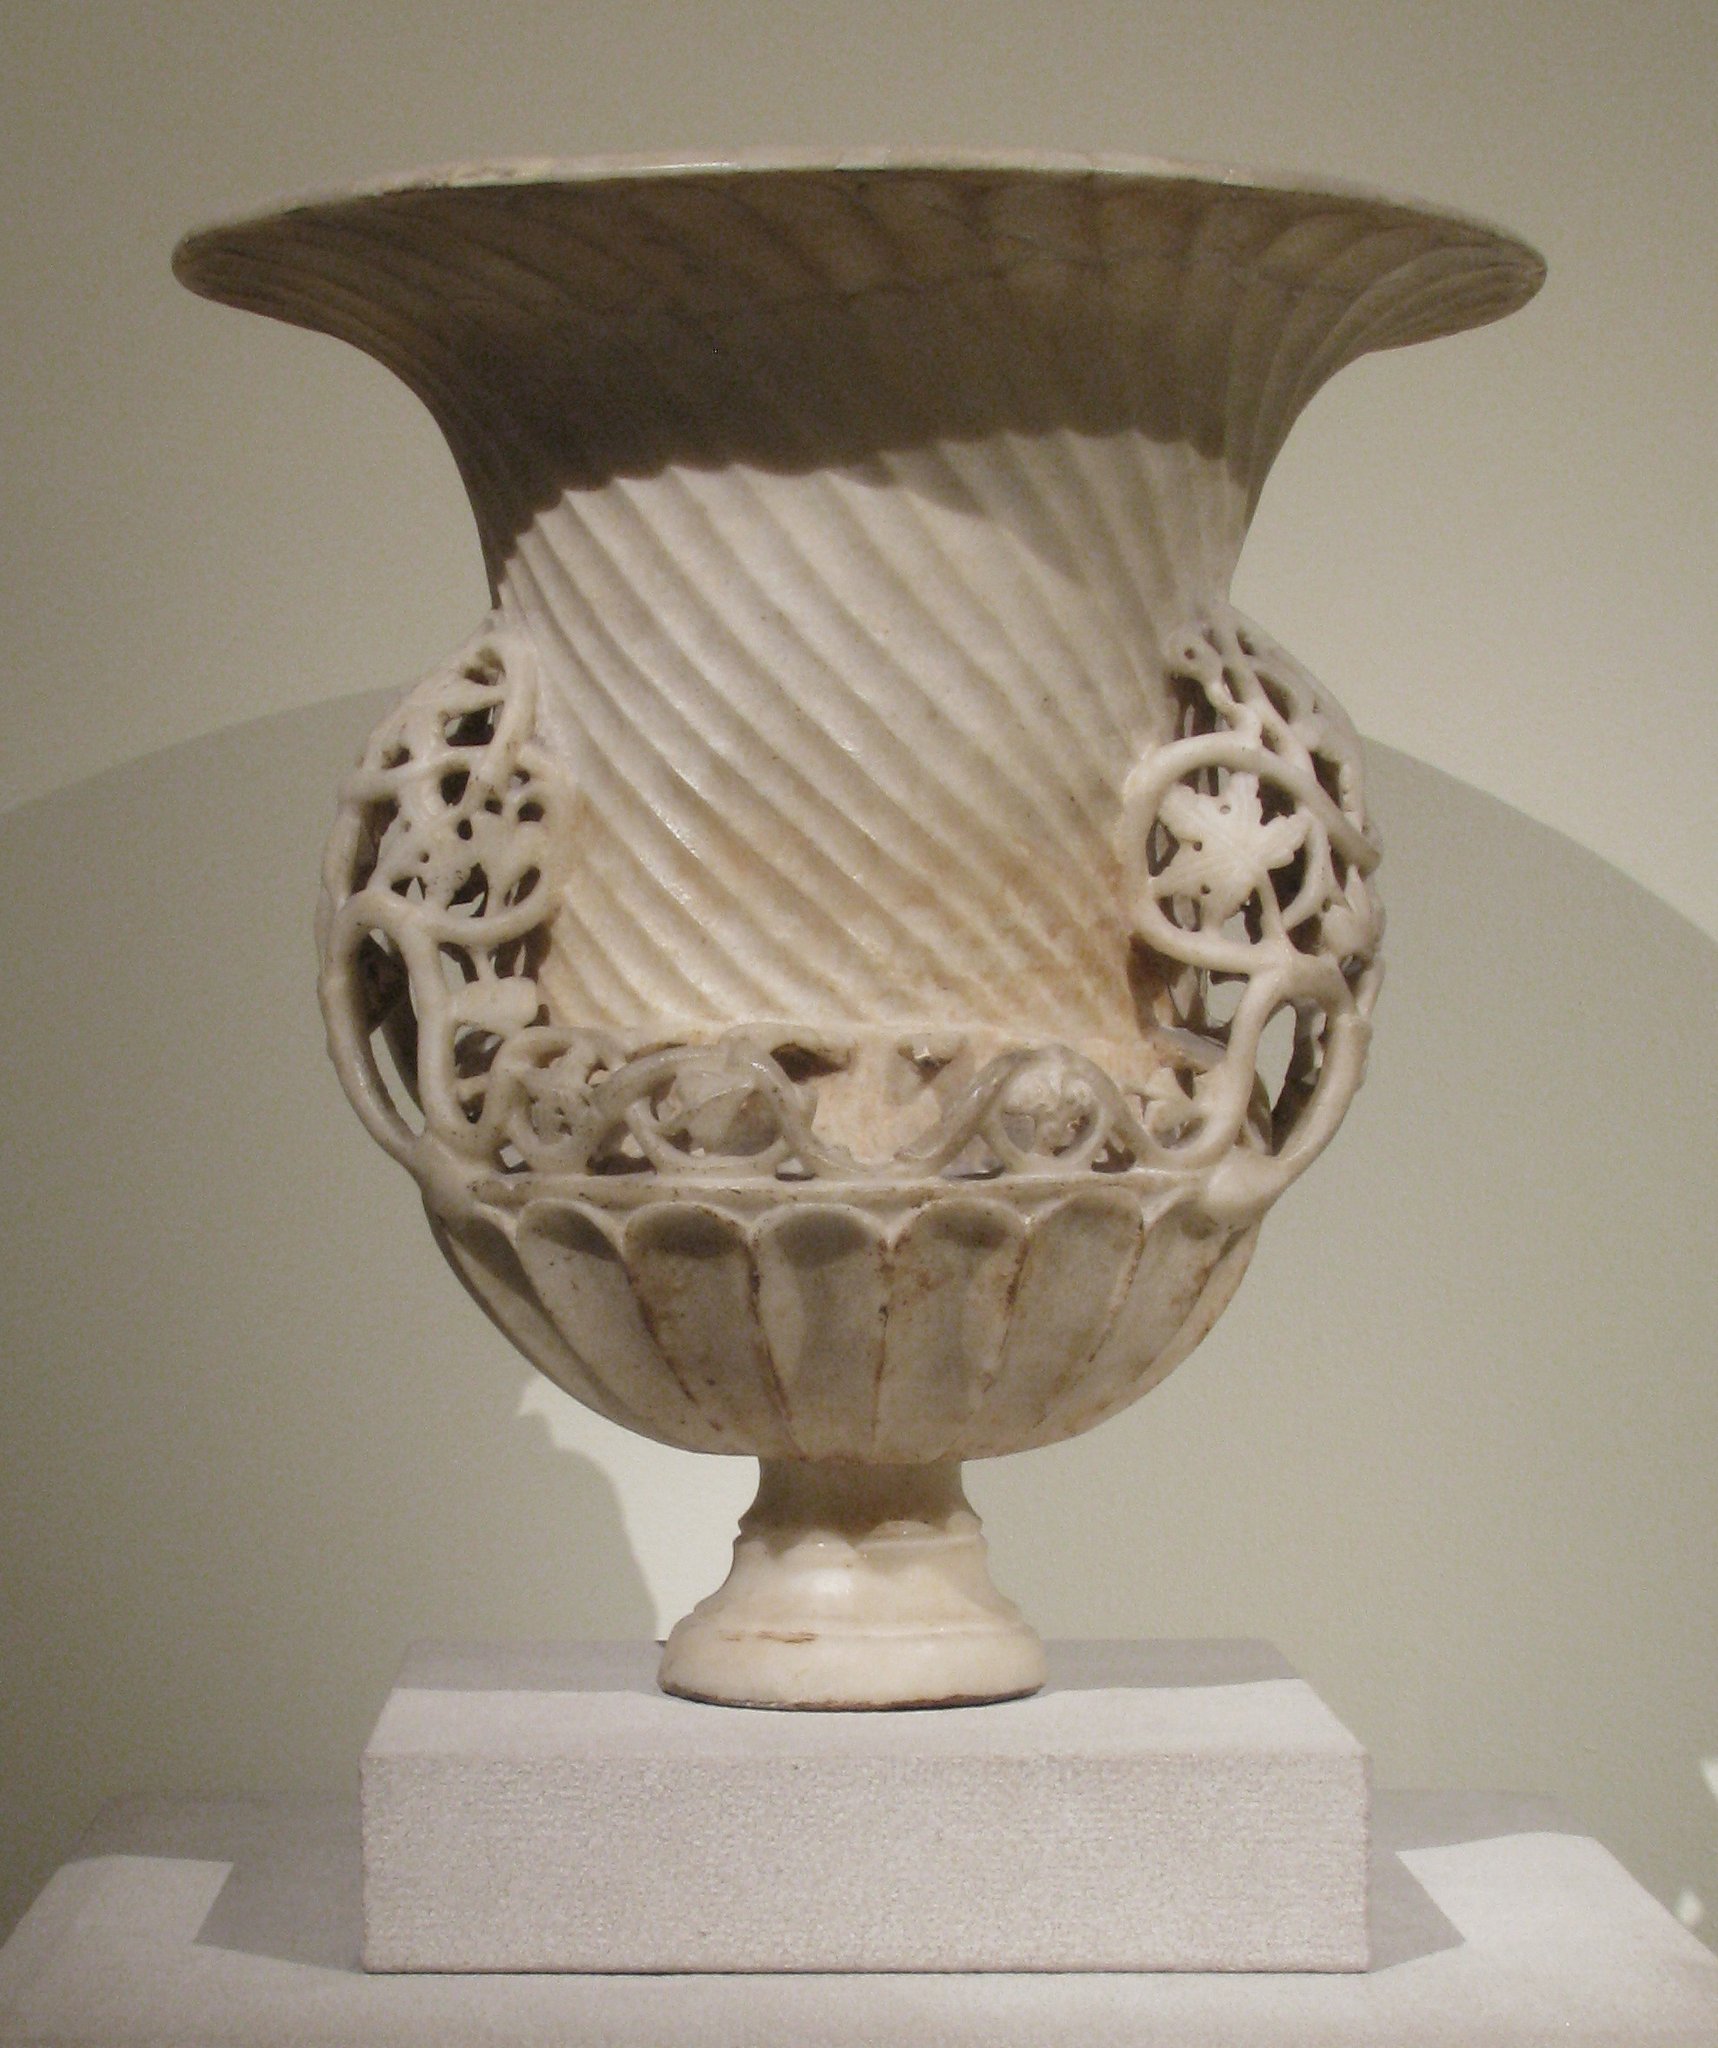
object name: vase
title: Marble Urn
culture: byzantine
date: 400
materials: marble